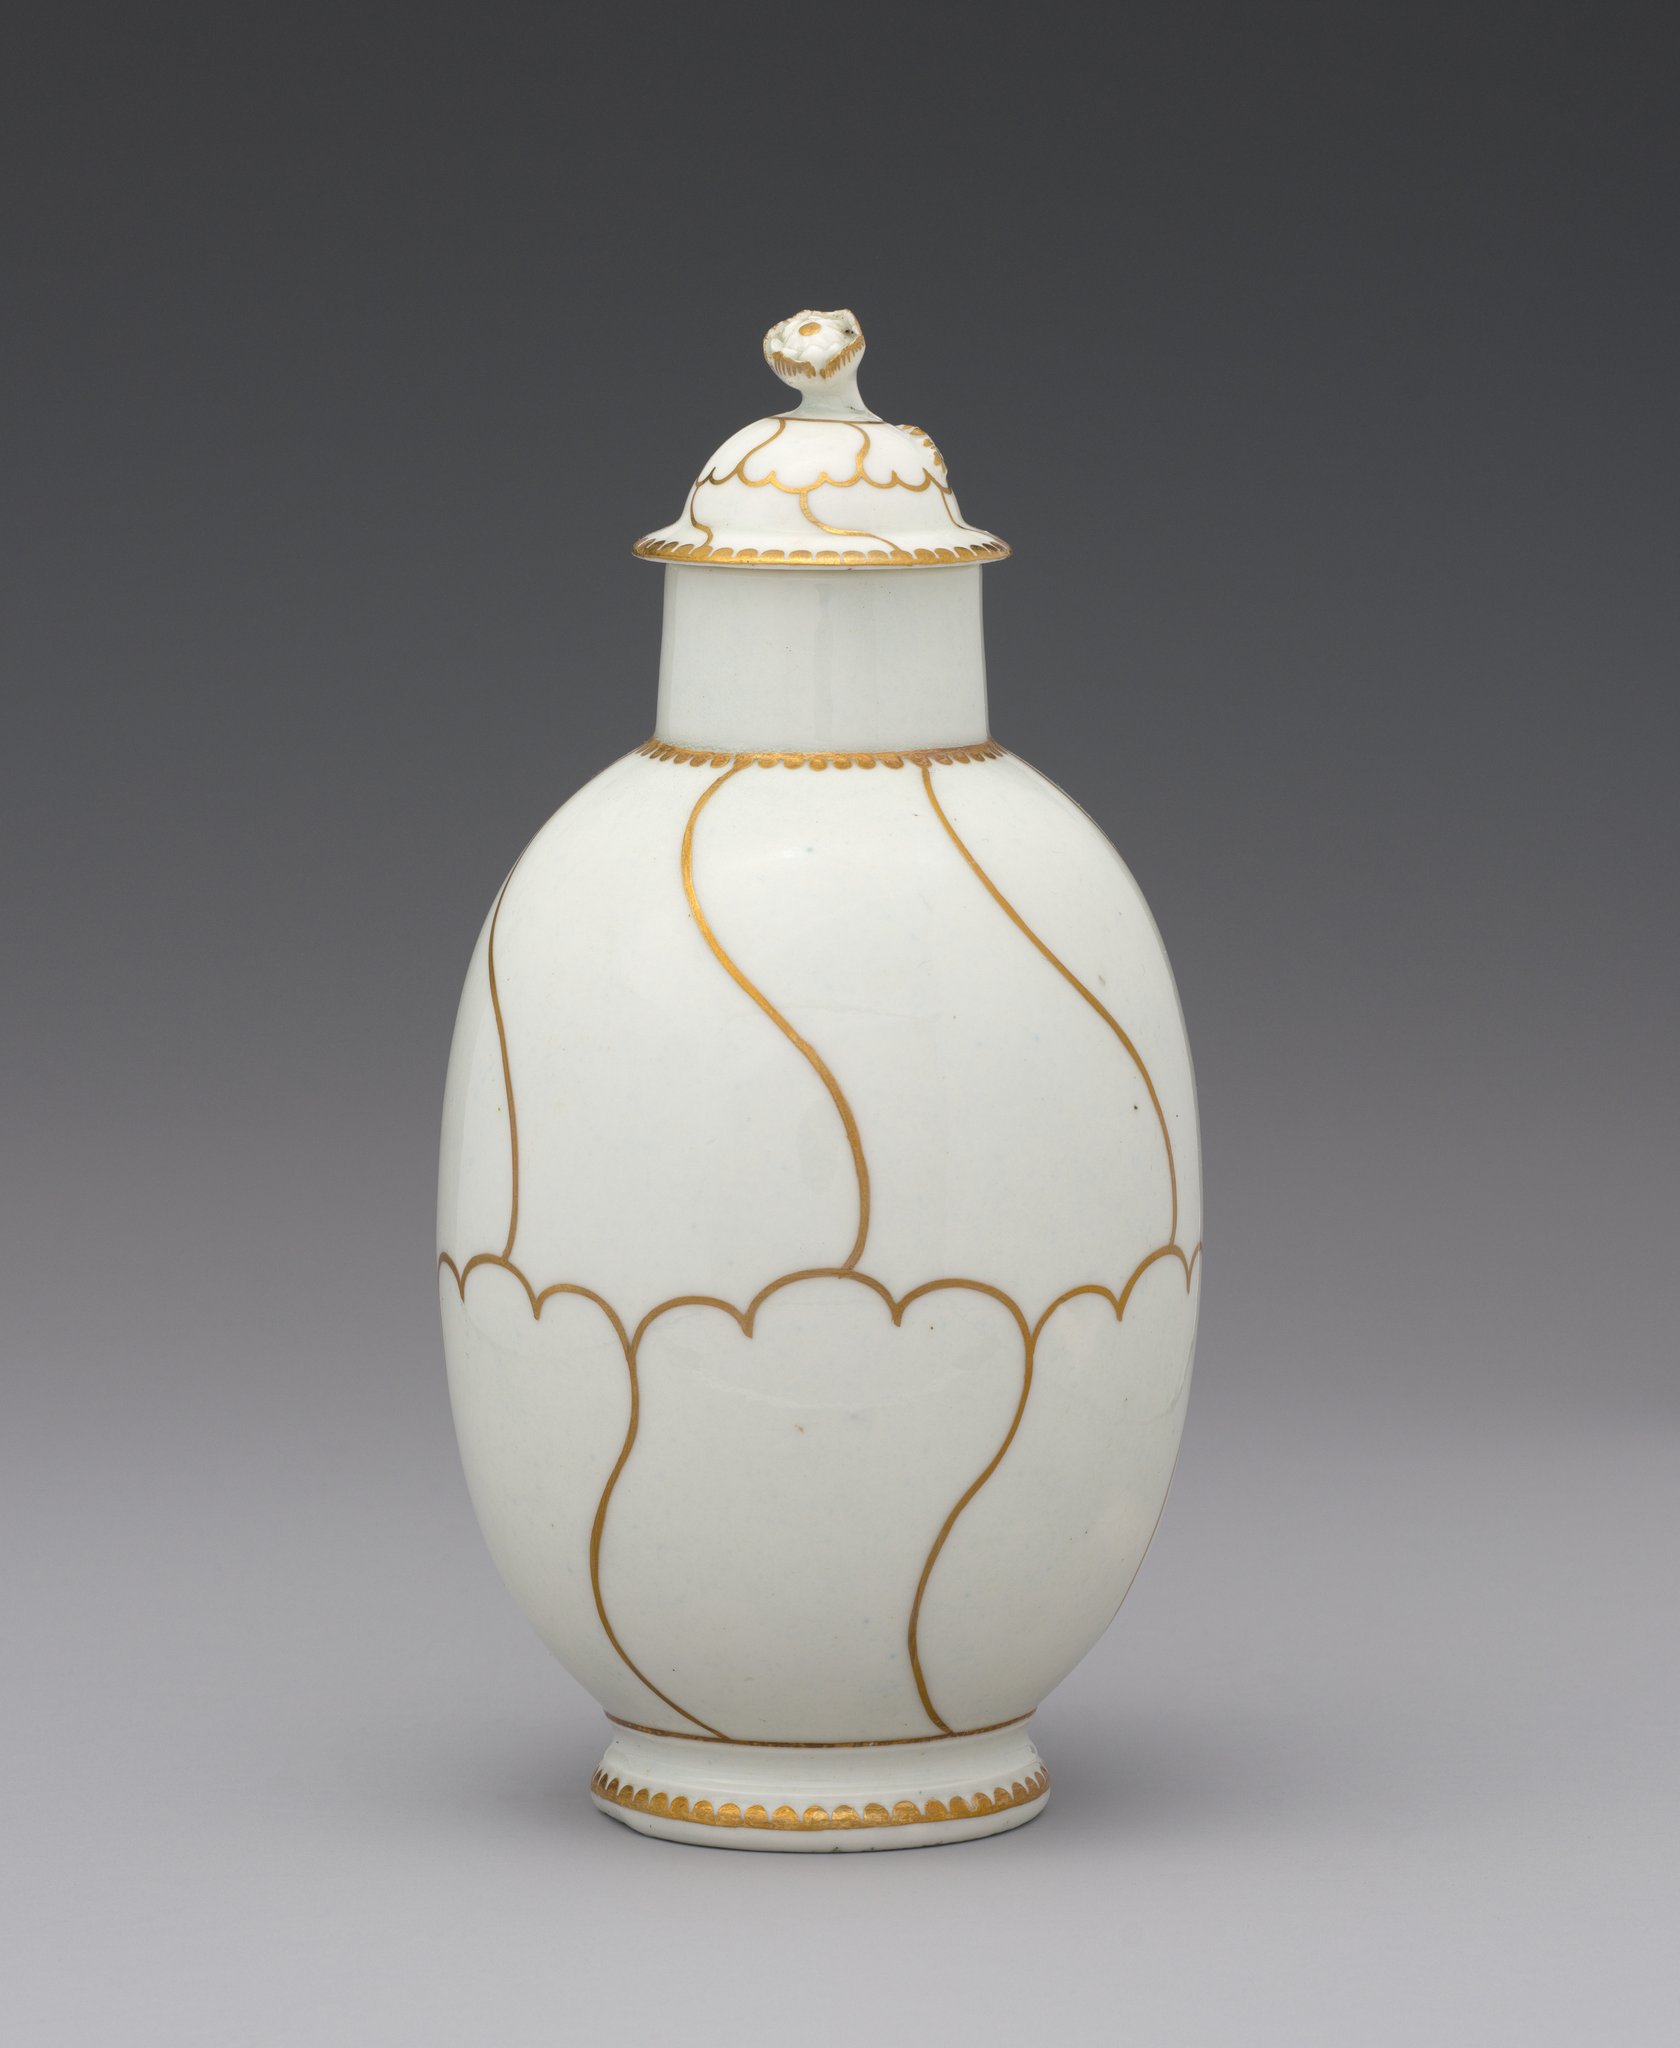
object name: tea caddy with cover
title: Tea caddy with cover (part of a service)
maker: worcester factory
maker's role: factory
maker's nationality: british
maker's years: 1751-2008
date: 1775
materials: soft paste porcelain